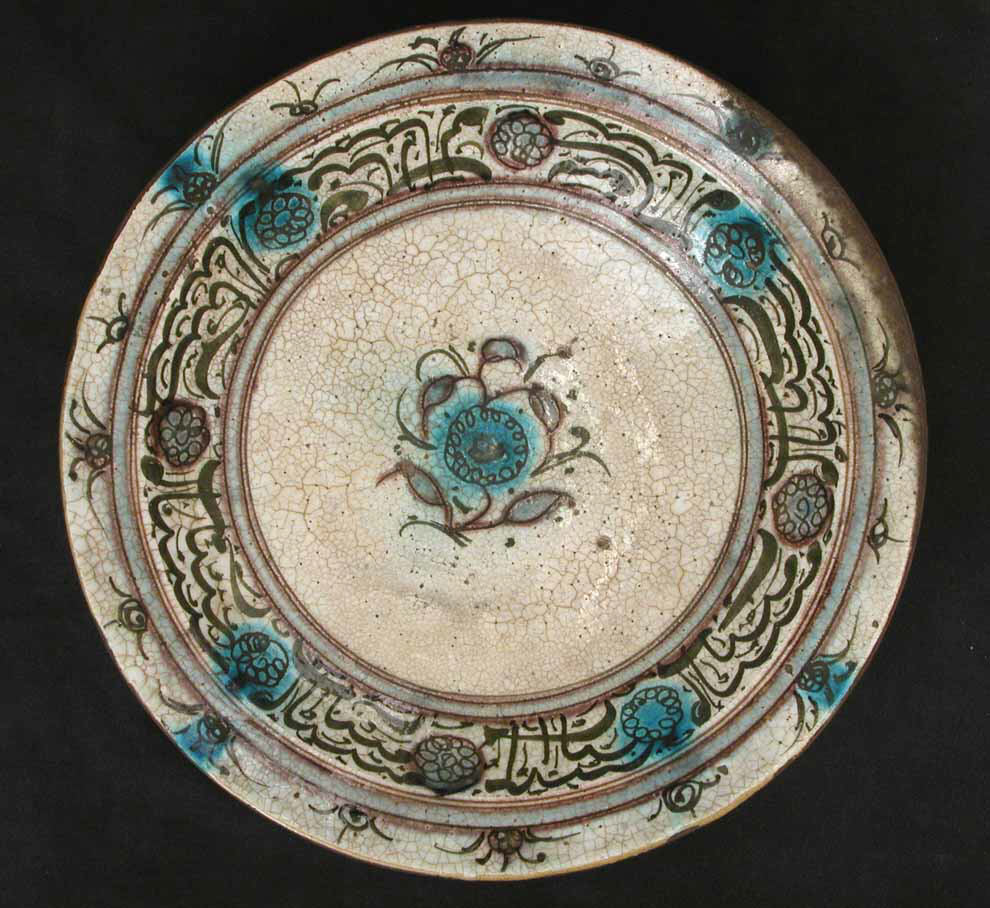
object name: bowl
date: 1701-1800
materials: pottery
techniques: glazing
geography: iran